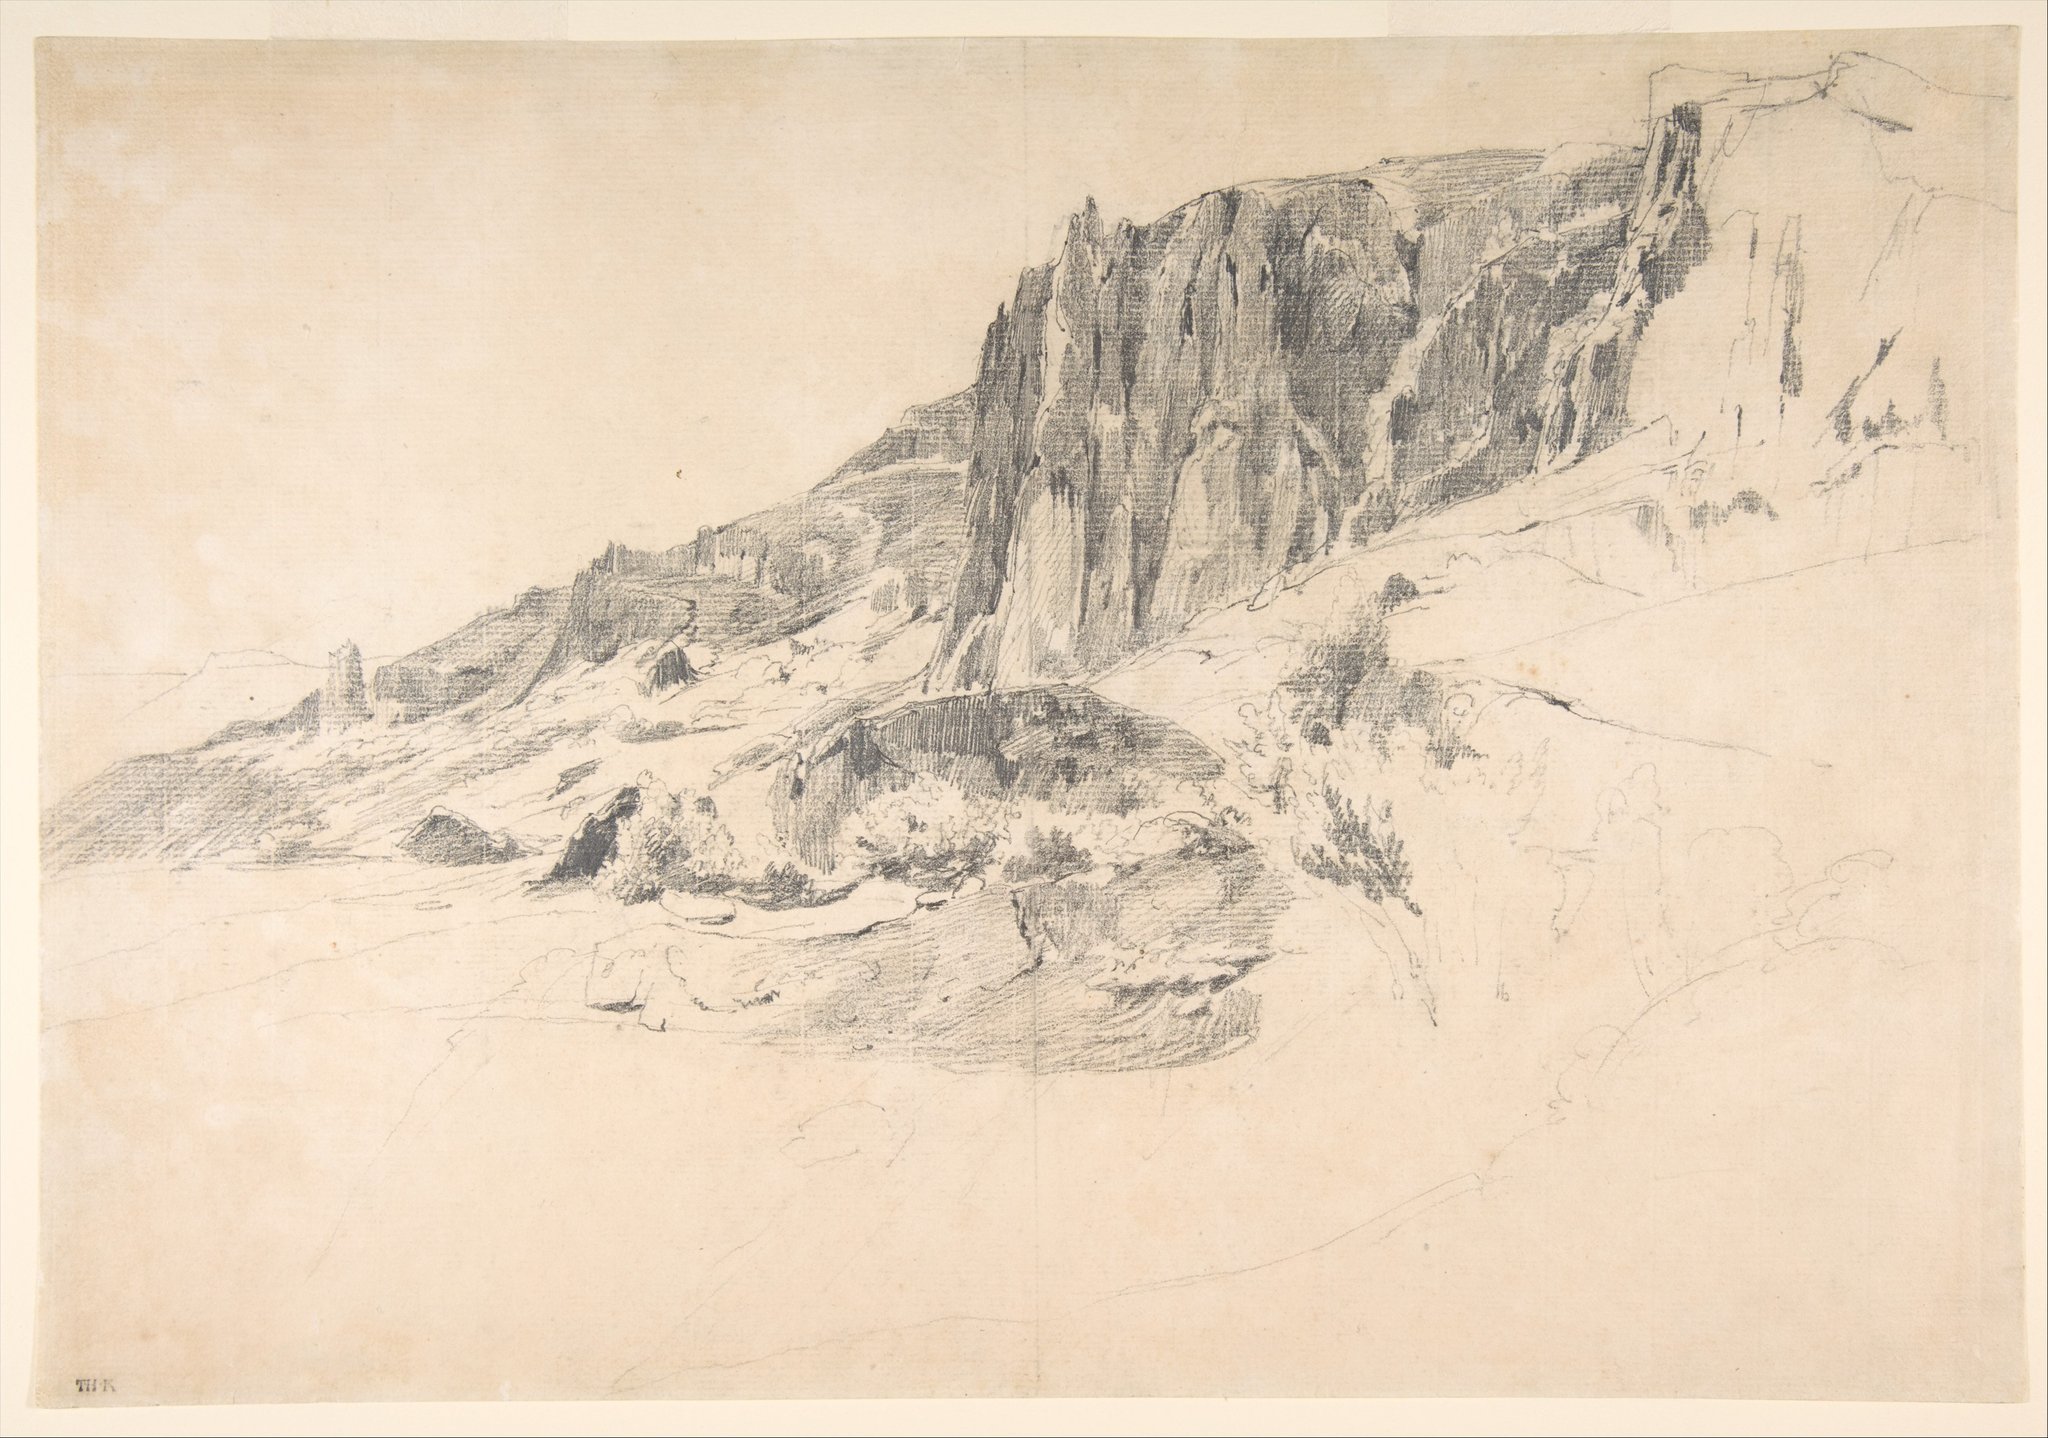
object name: drawing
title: Cliffs of Malbec at Mont-Dore, the Auvergne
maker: théodore rousseau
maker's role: artist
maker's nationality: french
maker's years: 1812-1867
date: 1830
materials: graphite, paper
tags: landscapes